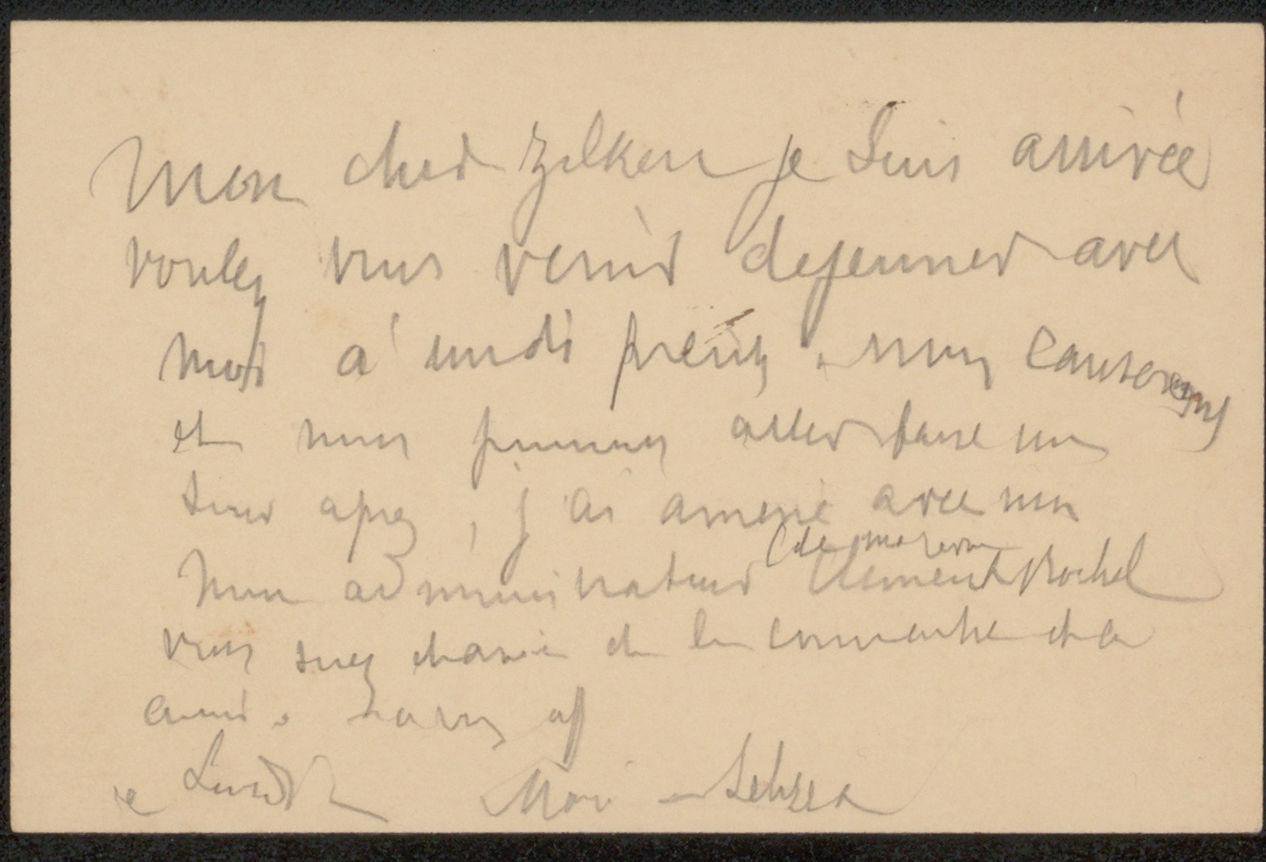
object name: letter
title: Brief aan Philip Zilcken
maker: Anonymous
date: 1867-1930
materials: cardboard, pencil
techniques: printing, writing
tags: clément rochel, painter, draughtsman, philip zilcken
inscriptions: collector's mark: ‘RPK’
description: Brief is geschreven op de achterzijde van een visitekaartje. De gegevens op dit visitekaartje zijn doorgestreept.